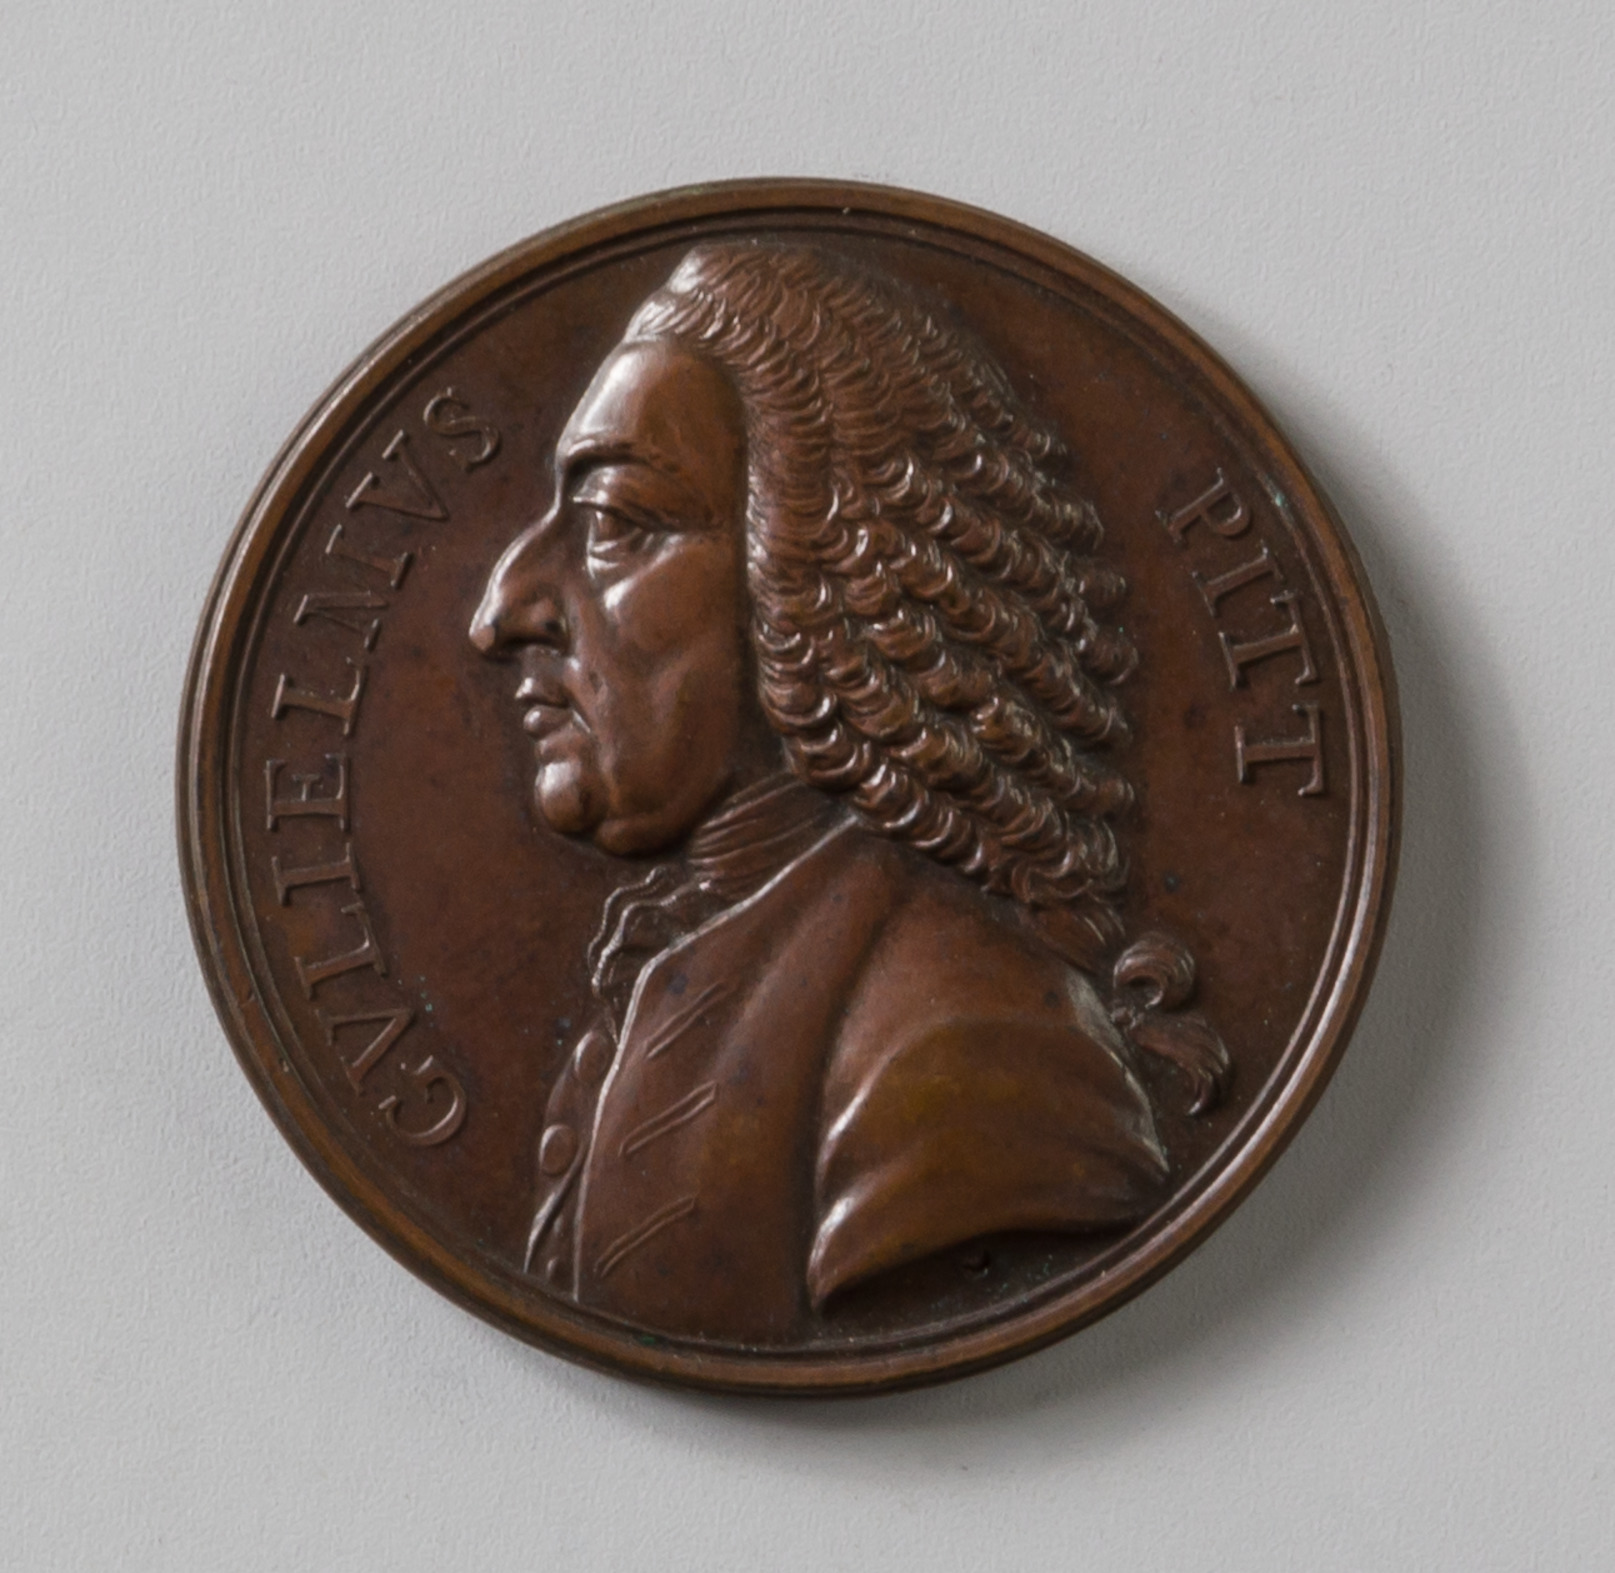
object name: medal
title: Medal Commemorating the Opposition of William Pitt to the Colonial Policy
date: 1770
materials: bronze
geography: england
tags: men,profiles